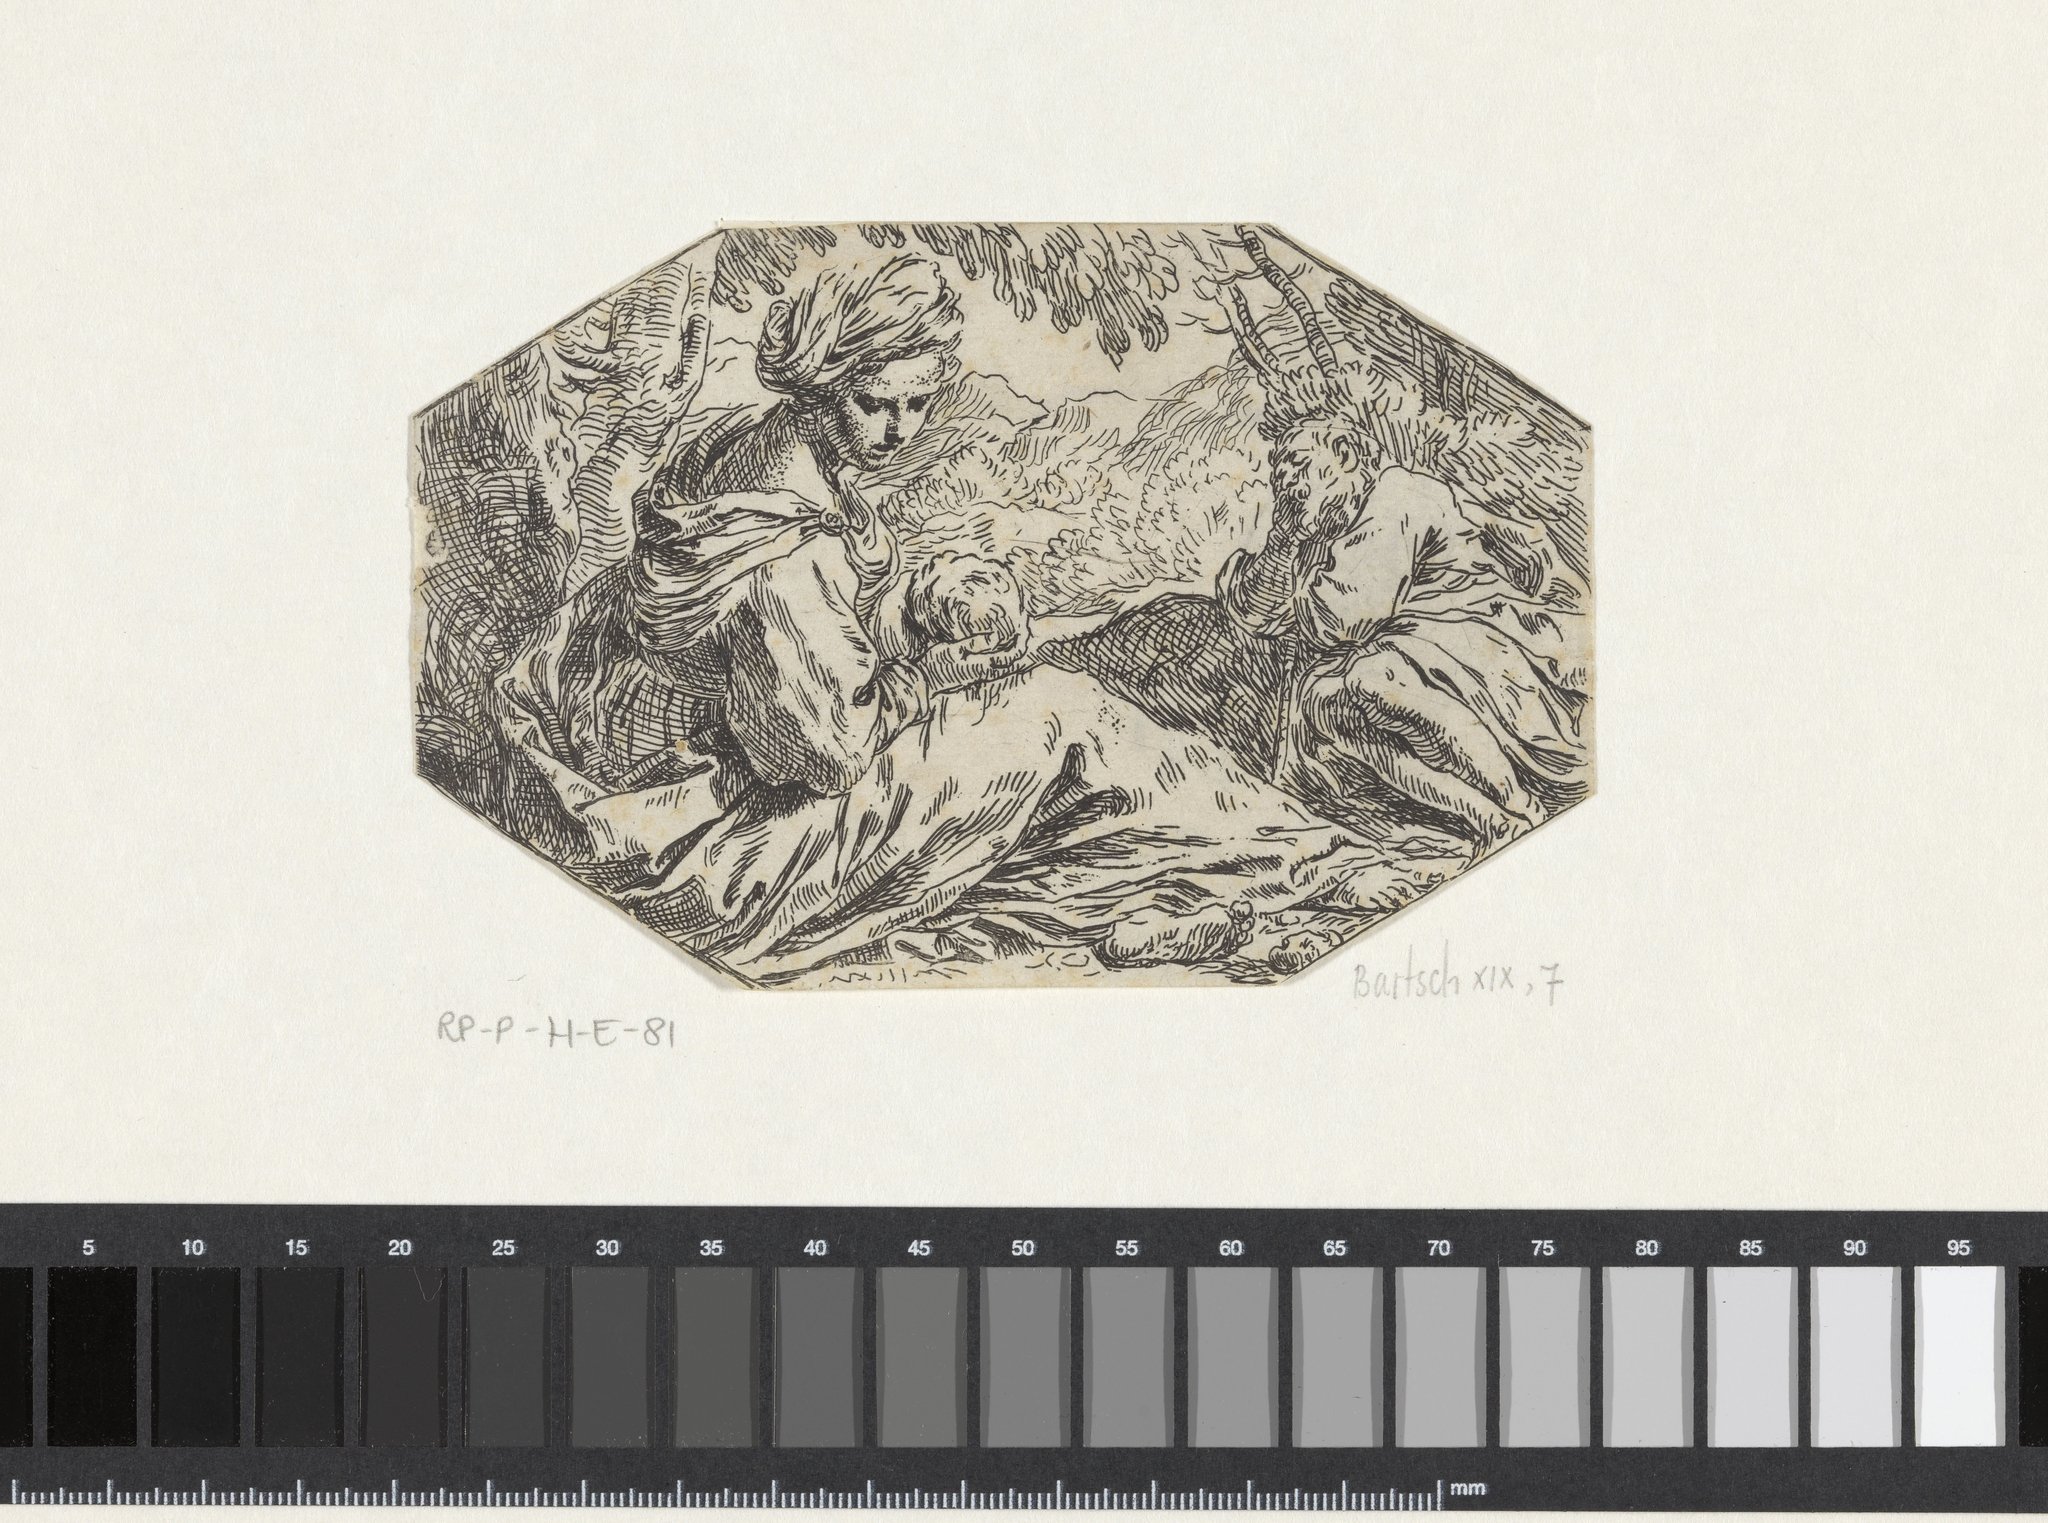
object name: print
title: Rust op de vlucht naar Egypte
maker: simone cantarini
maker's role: draughtsman, print maker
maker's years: 1612-1648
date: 1622-1648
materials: paper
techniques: etching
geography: italy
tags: the flight into egypt: mary, joseph, the child (and sometimes others) on their way; mary usually riding on an ass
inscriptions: collector's mark: Lugt 11, collector's mark: ‘Hinloopen’, collector's mark: Lugt 10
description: De Heilige Familie rust in een landschap tijdens de vlucht naar Egypte. Het Christuskind ligt op schoot bij Maria. Op de achtergrond rechts slaapt Jozef.